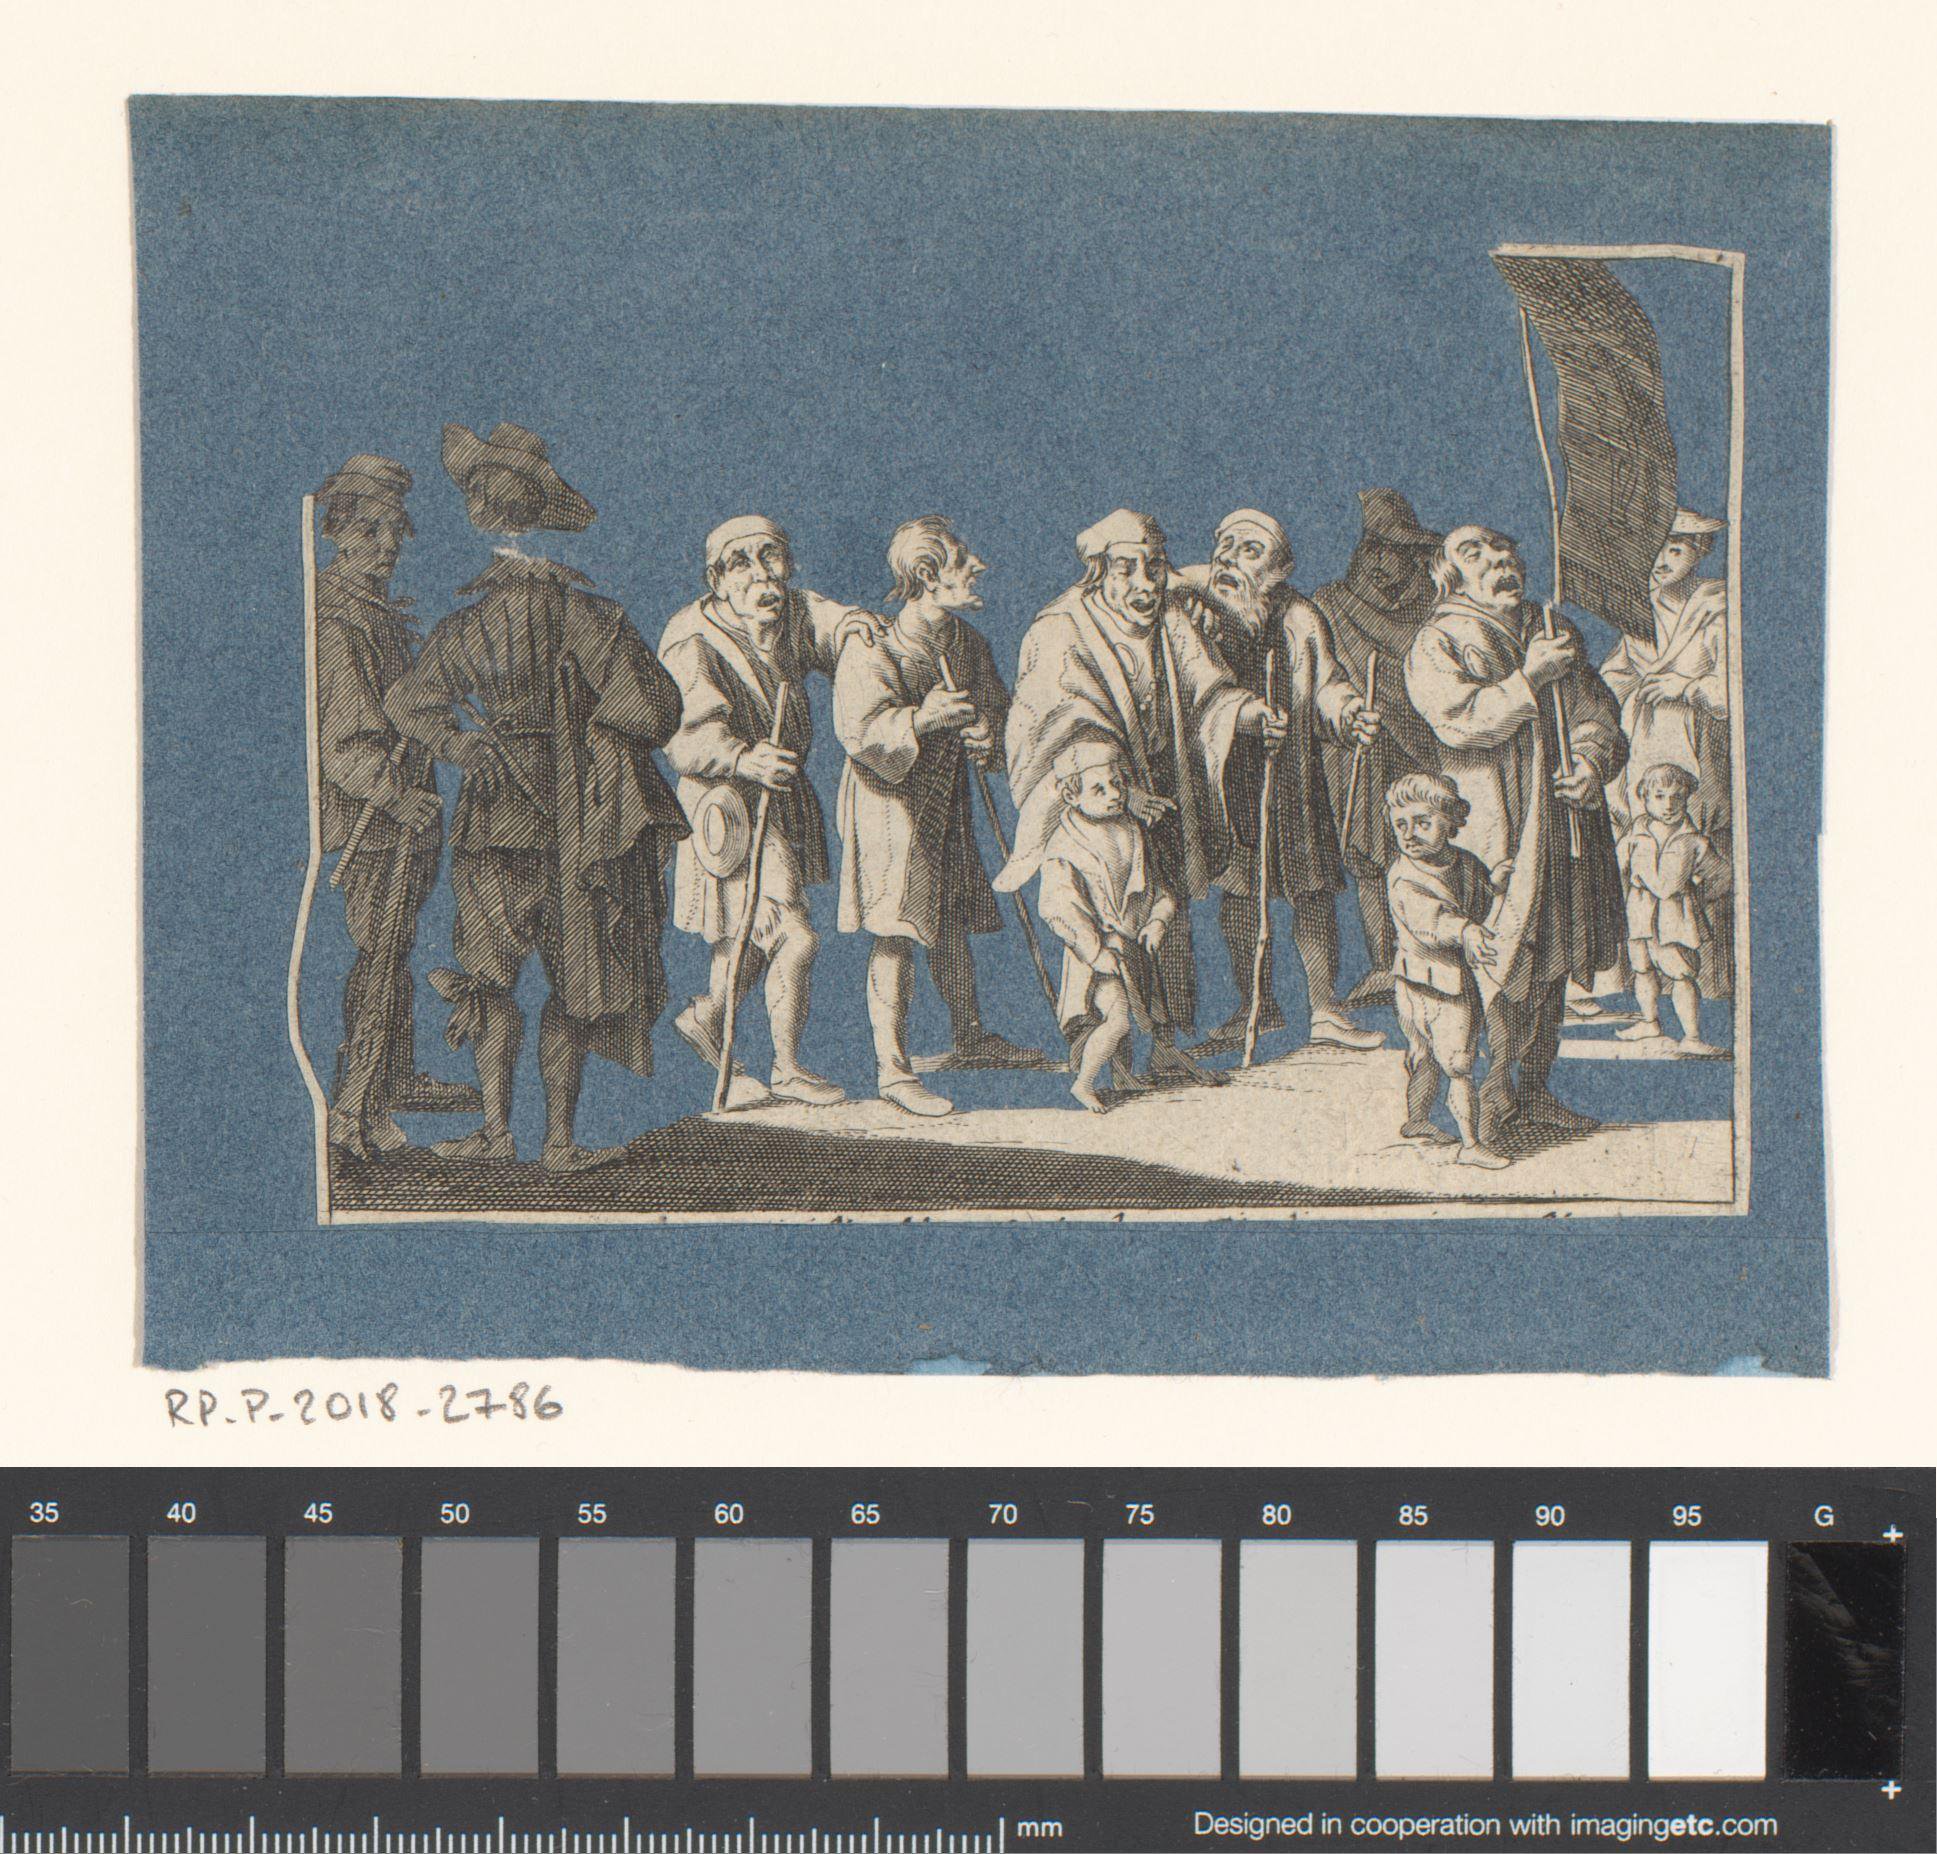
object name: print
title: Fragment van een collage van uitgeknipte prenten, geplakt op blauw papier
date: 1680-1720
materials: paper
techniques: etching, snipping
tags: blind, blindness, procession ~ christian religion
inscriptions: collector's mark: Lugt 2760, collector's mark: Lugt 2228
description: Optocht van blinden, voorafgegaan door een man met een vaandel. Fragment van een collage van uitgeknipte prenten, geplakt op blauw papier.